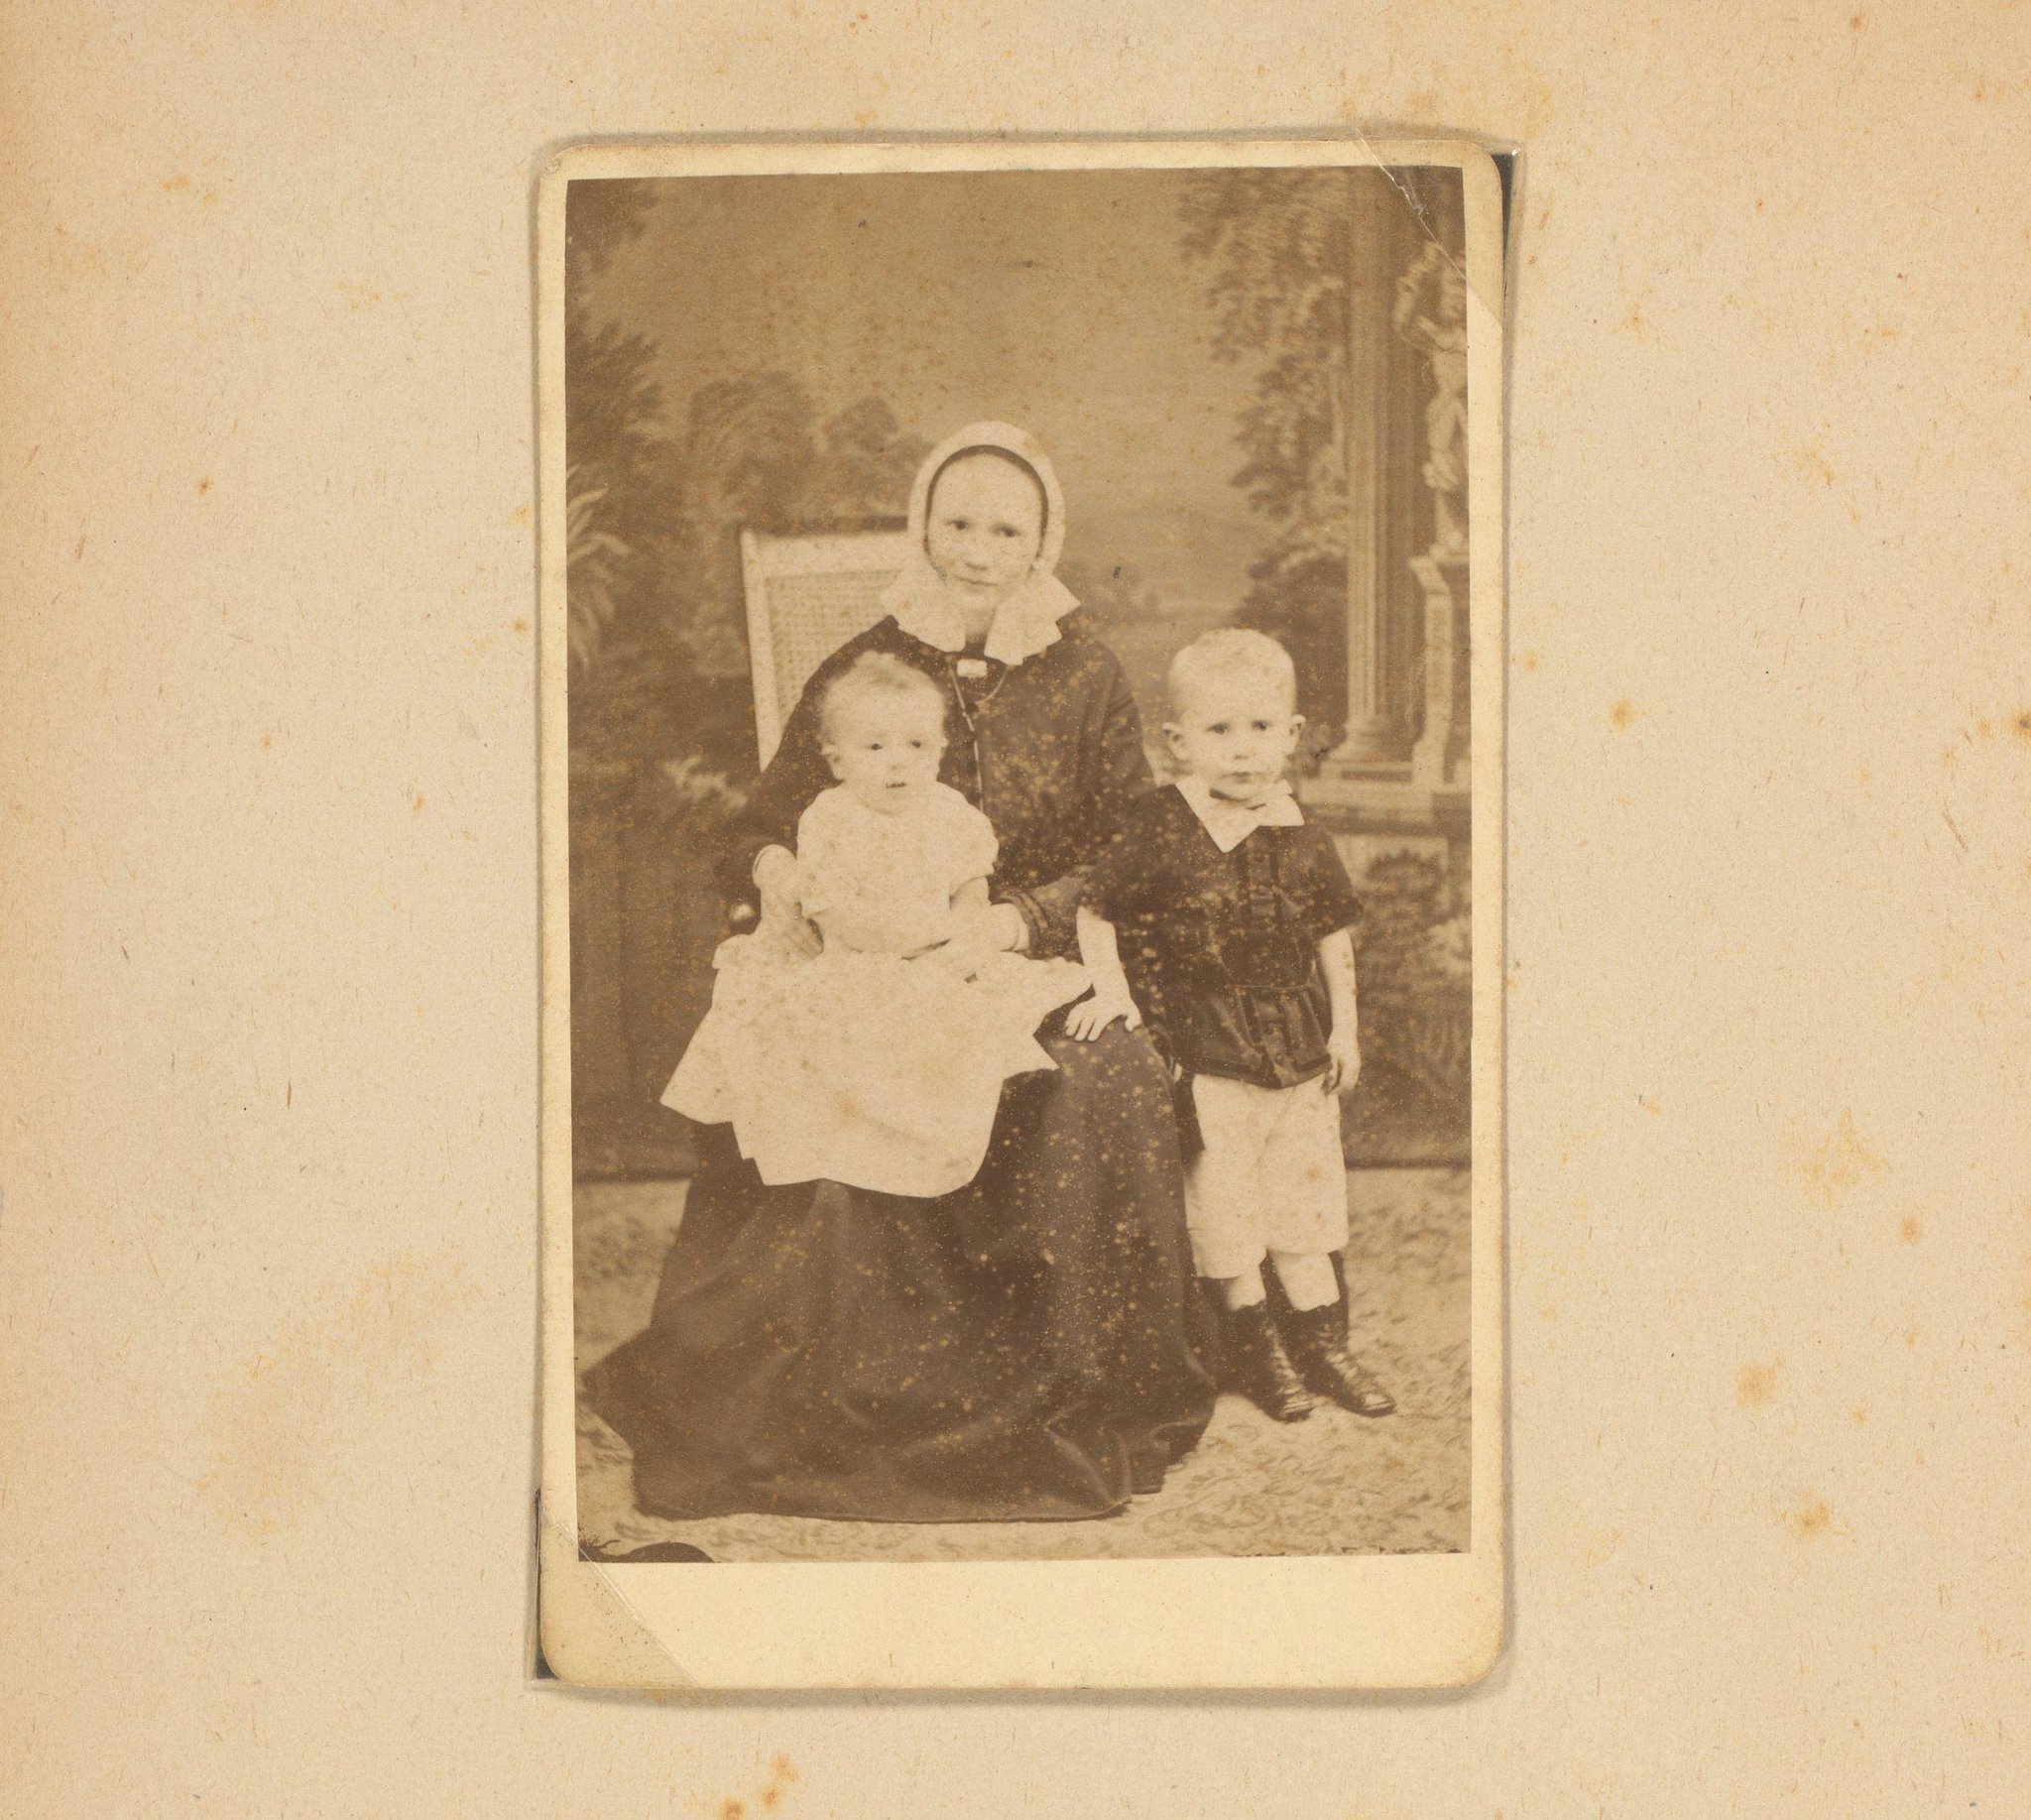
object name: photograph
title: Groepsportret met jonge vrouw en twee kinderen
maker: Anonymous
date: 1860-1900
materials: cardboard, photographic support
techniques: albumen print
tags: adolescent, young woman, maiden, child, anonymous historical persons portrayed in a group, in a group-portrait